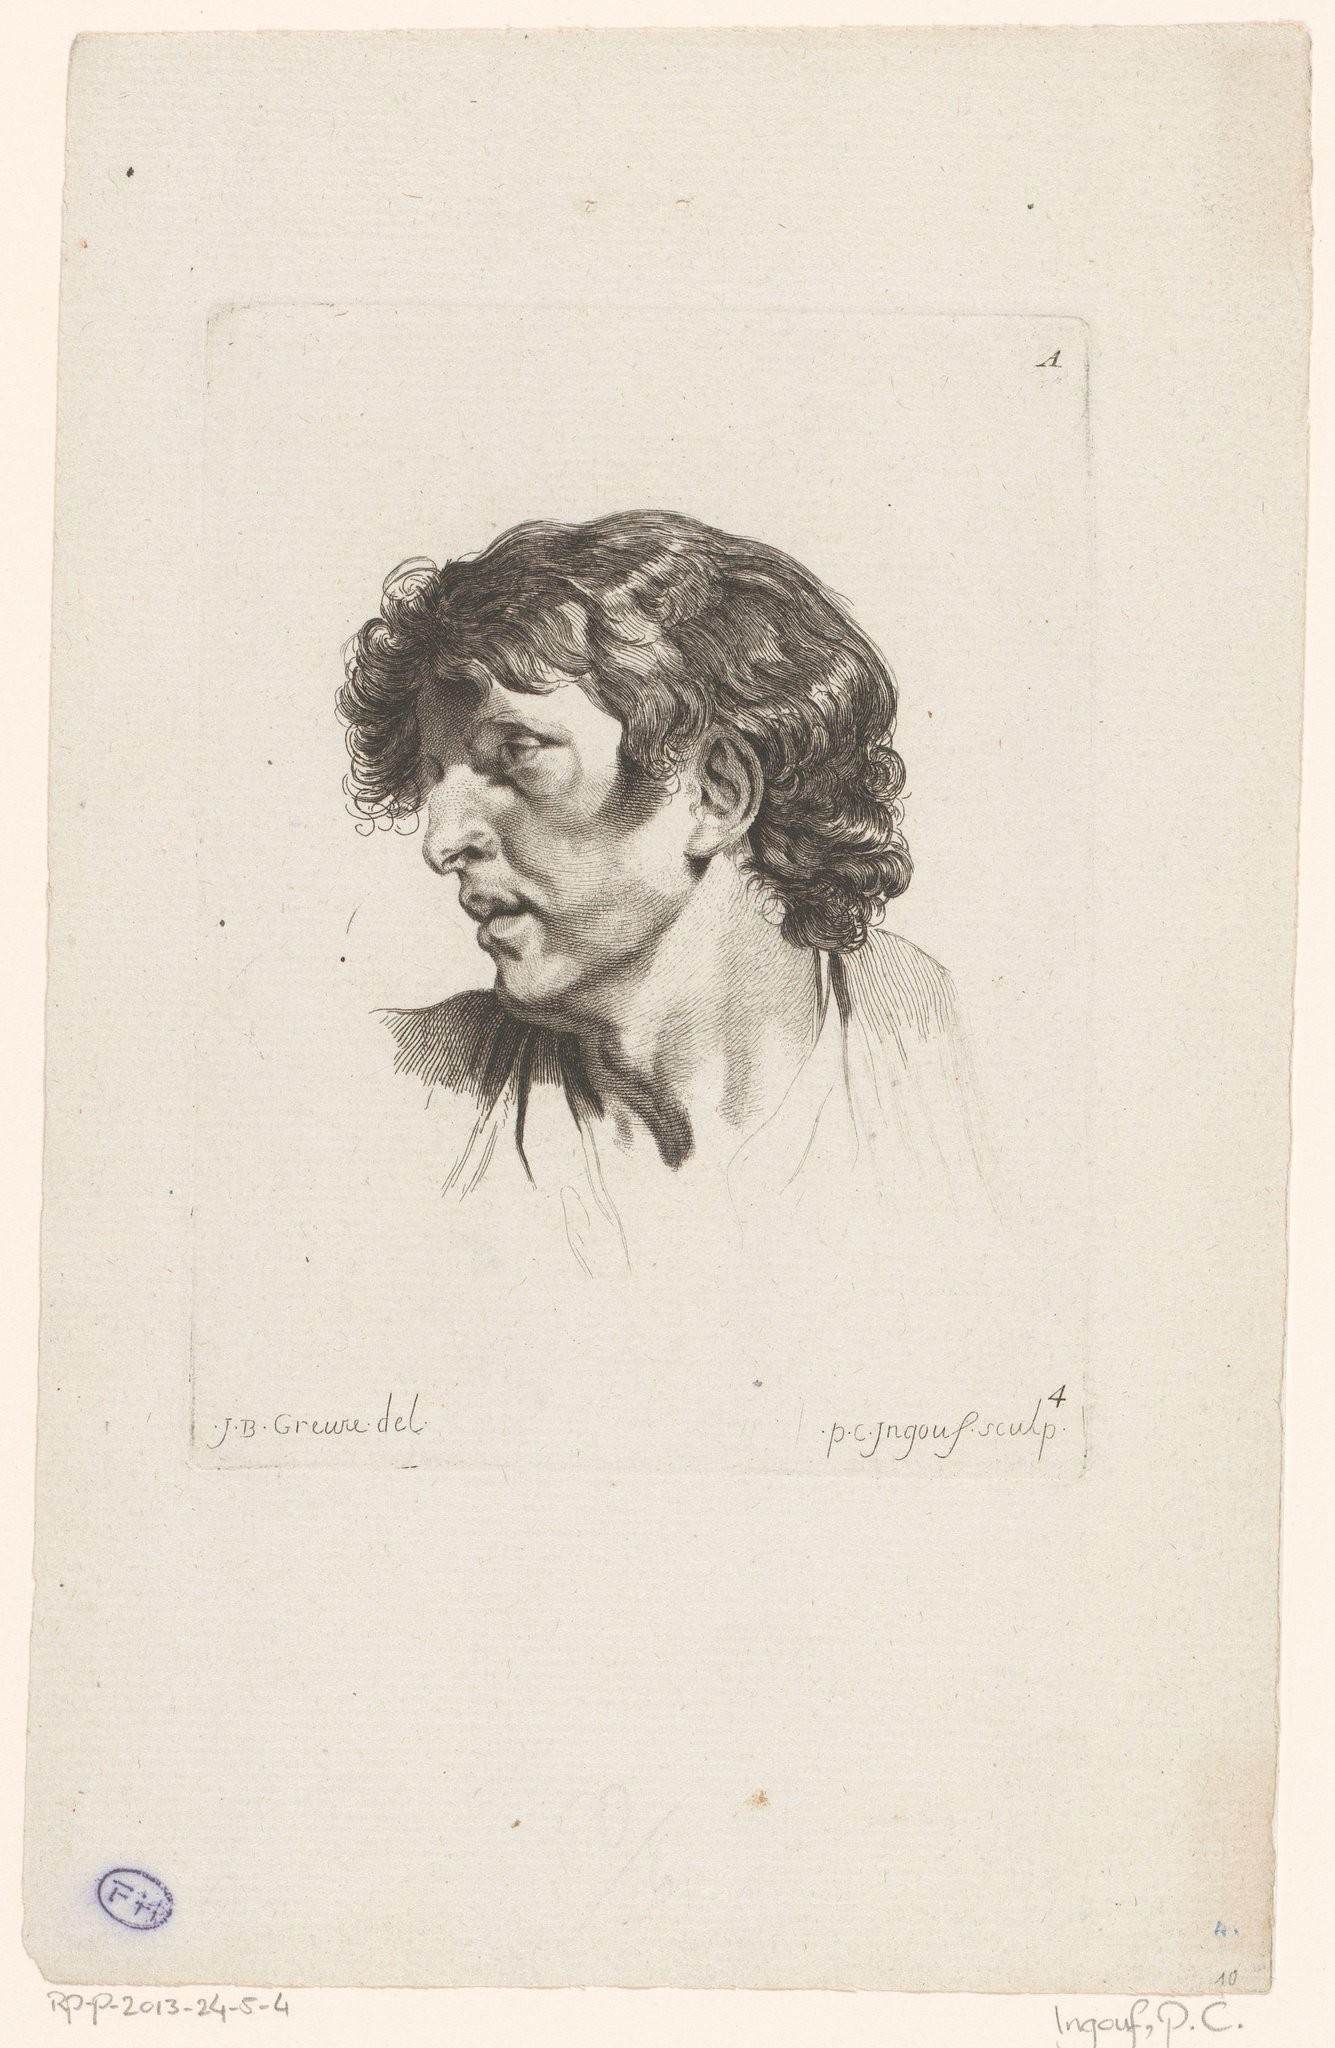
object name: print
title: Hoofden van verschillende figuren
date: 1766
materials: paper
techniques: engraving, etching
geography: france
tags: head (human), youth, adolescent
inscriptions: number: ‘a // 4’, collector's mark: Lugt 3373, collector's mark: Lugt 2760, collector's mark: Lugt 2228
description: Maakt deel uit van een negendelige serie met hoofden van verschillende figuren.